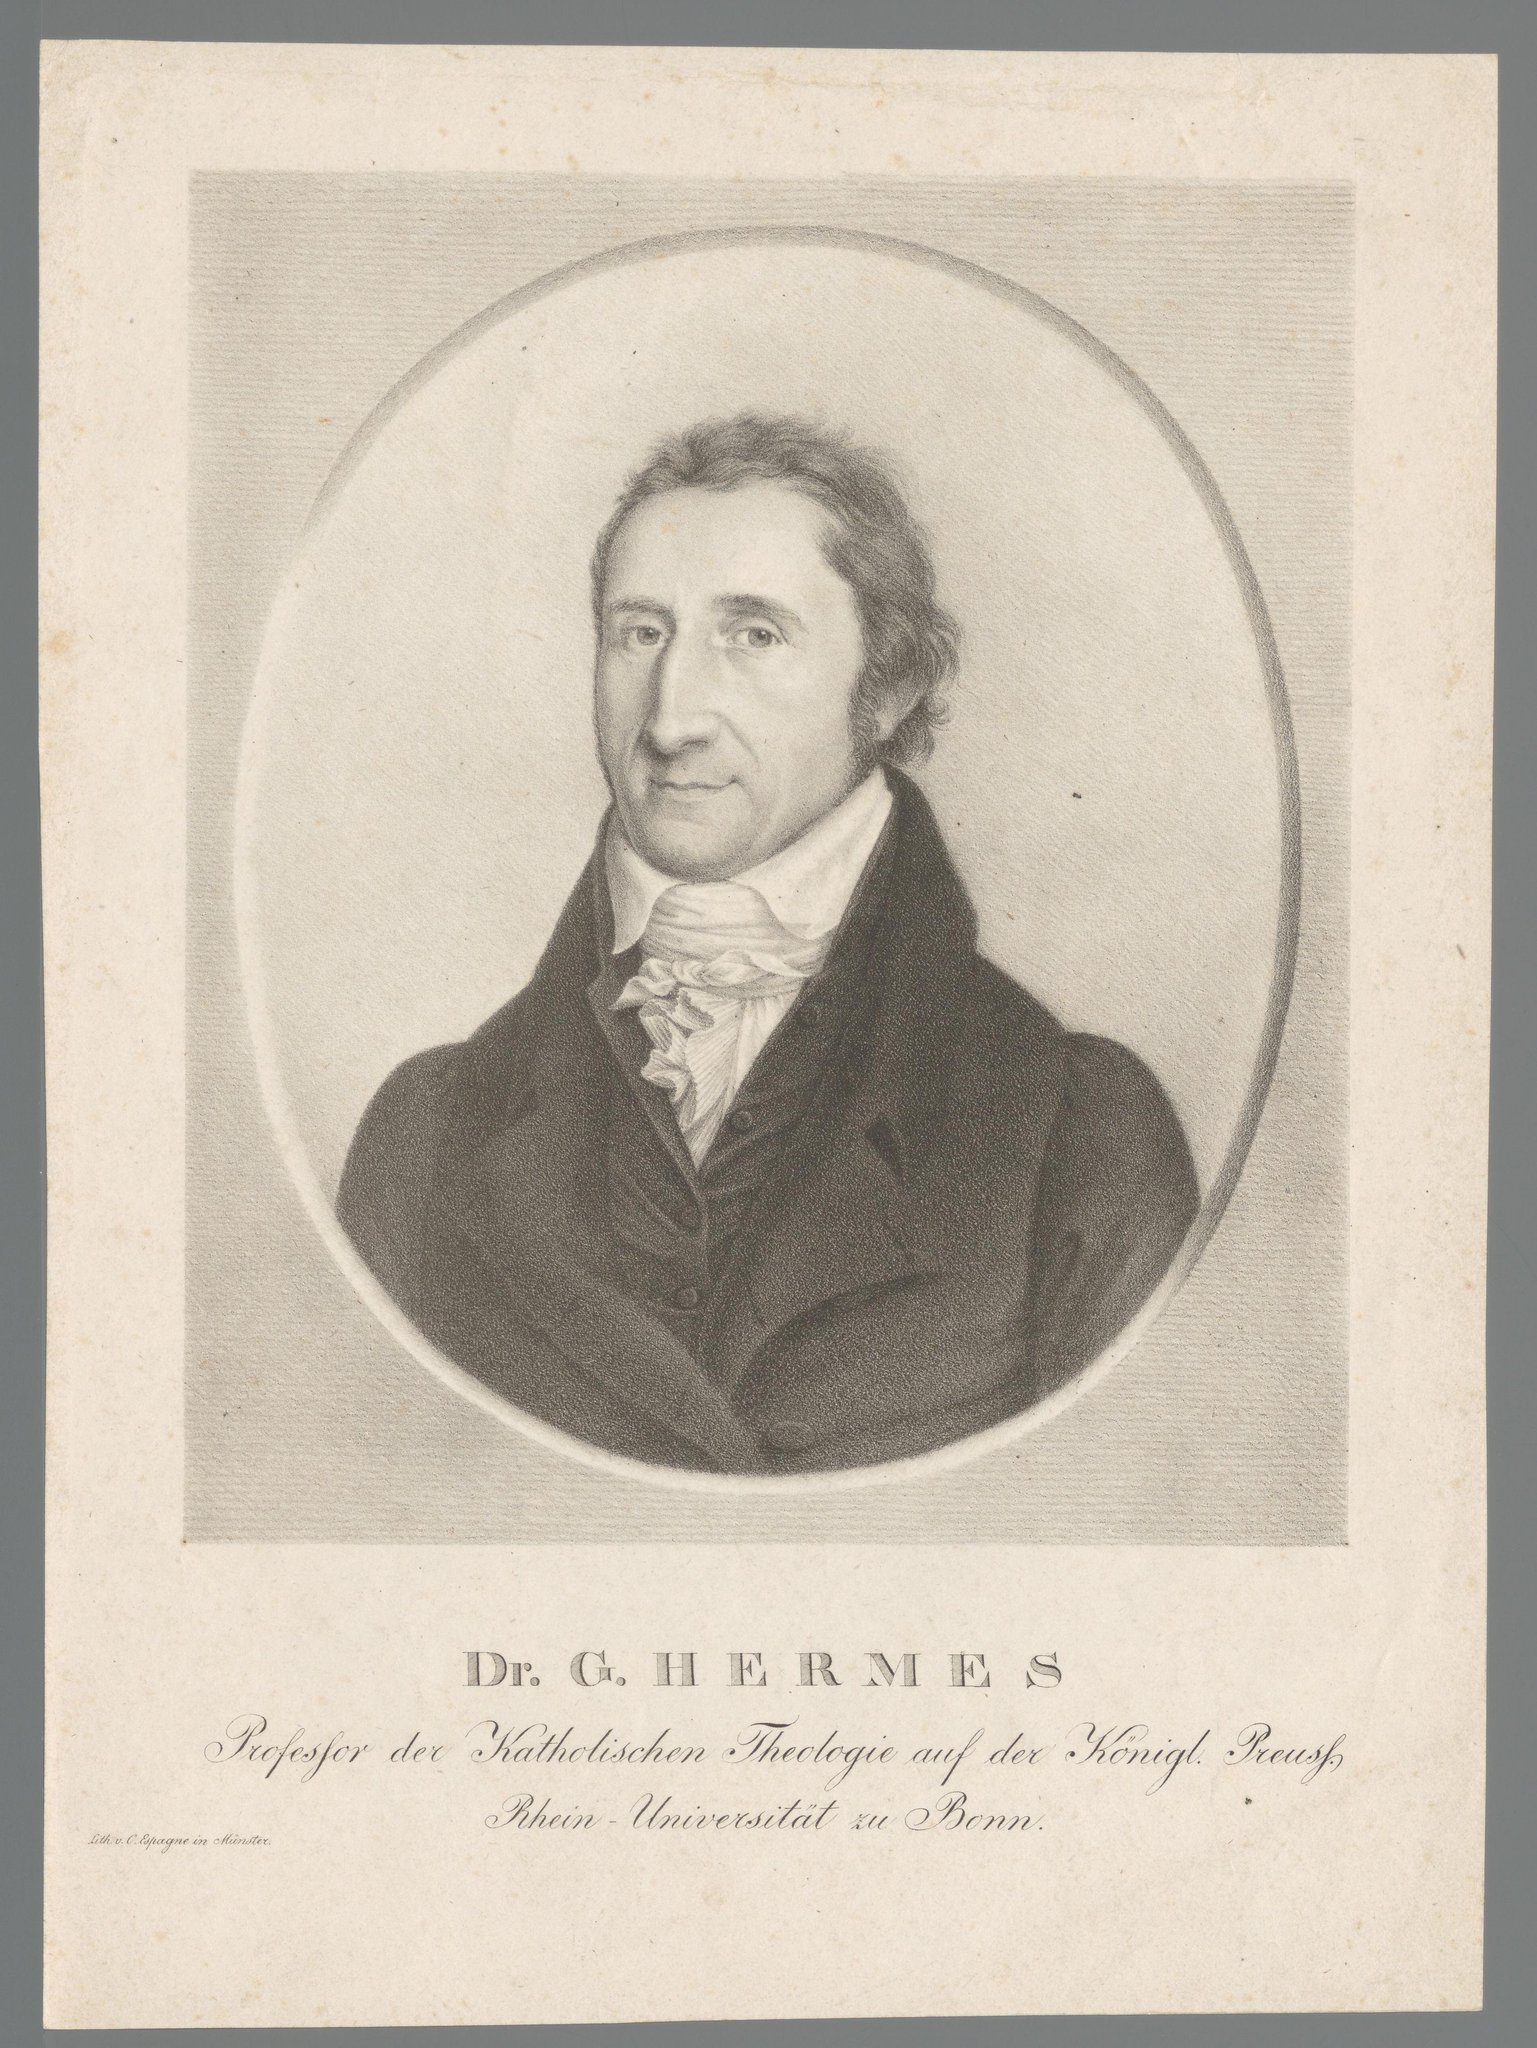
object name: print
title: Portret van Georg Hermes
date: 1820-1838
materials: paper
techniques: lithograph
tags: adult man, historical persons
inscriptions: collector's mark: Lugt 2228